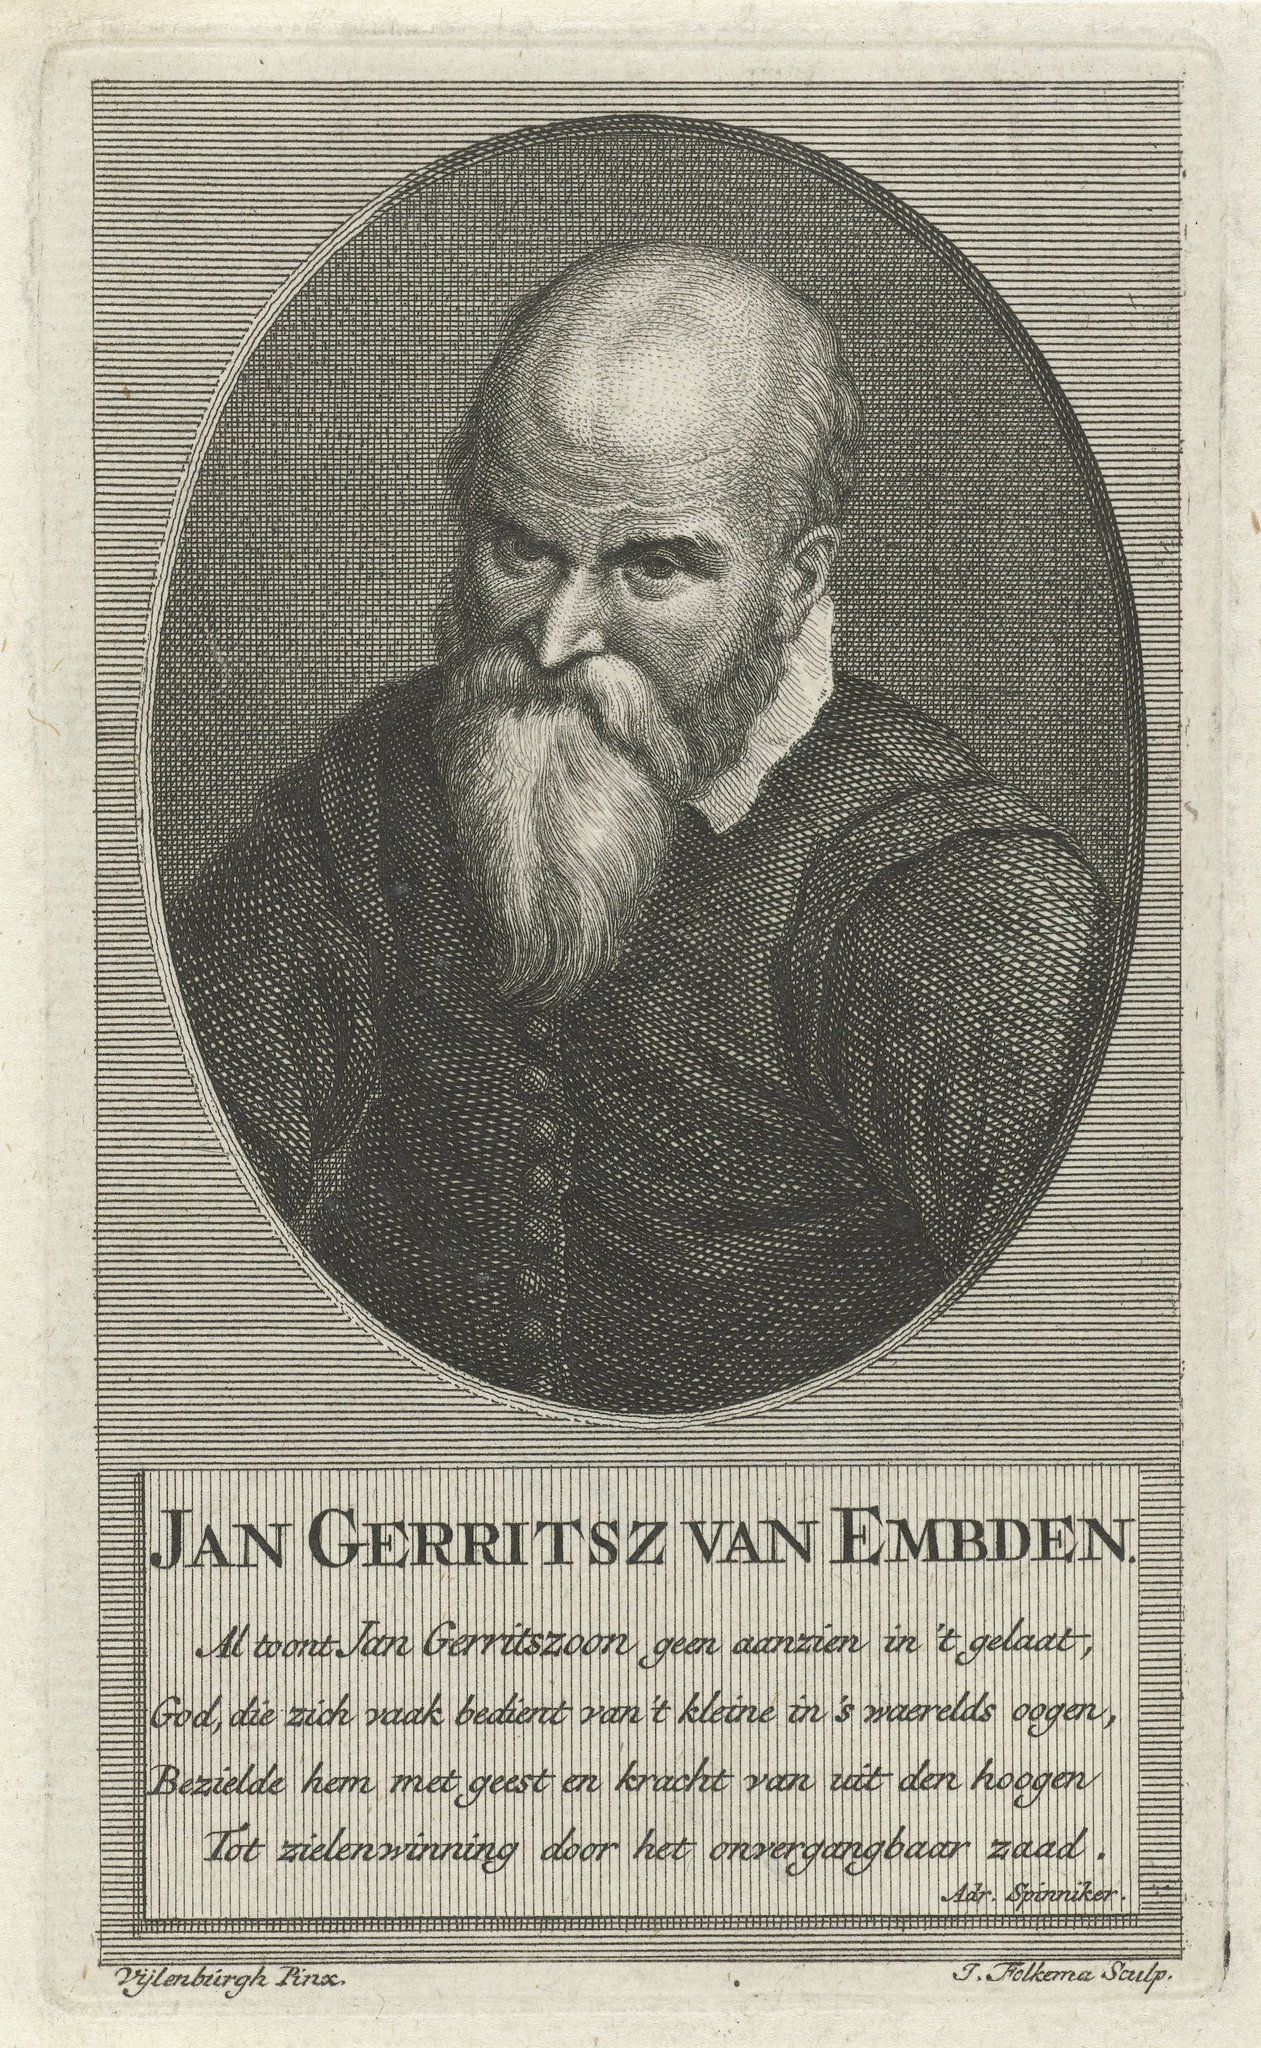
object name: print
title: Portret van Jan Gerrits van Embden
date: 1702-1767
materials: paper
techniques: engraving, etching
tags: predikant, jan gerrits van emden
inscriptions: collector's mark: Lugt 2228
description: Portretbuste in ovaal van predikant Jan Gerrits van Embden, blootshoofds en iets naar links. Onder het portret staan de naam van de geportretteerde en een vierregelig vers in het Nederlands.